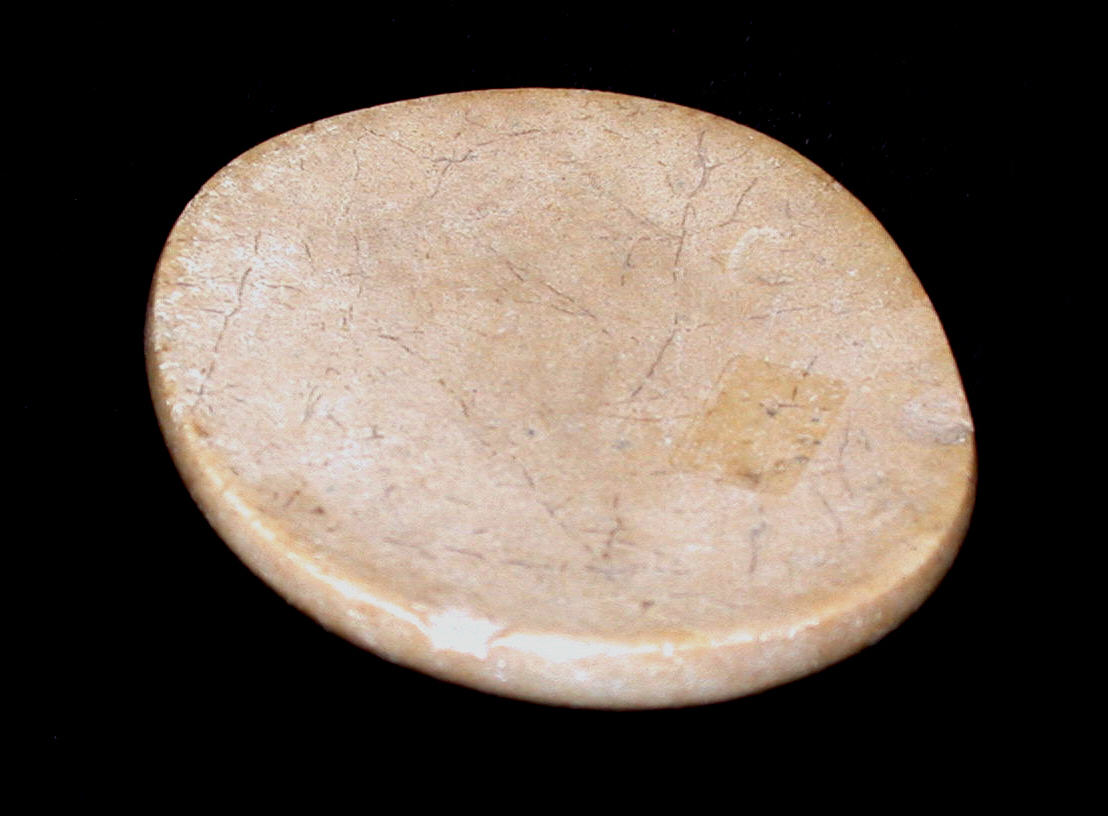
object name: mortar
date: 7000-5001 BCE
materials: limestone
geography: syria